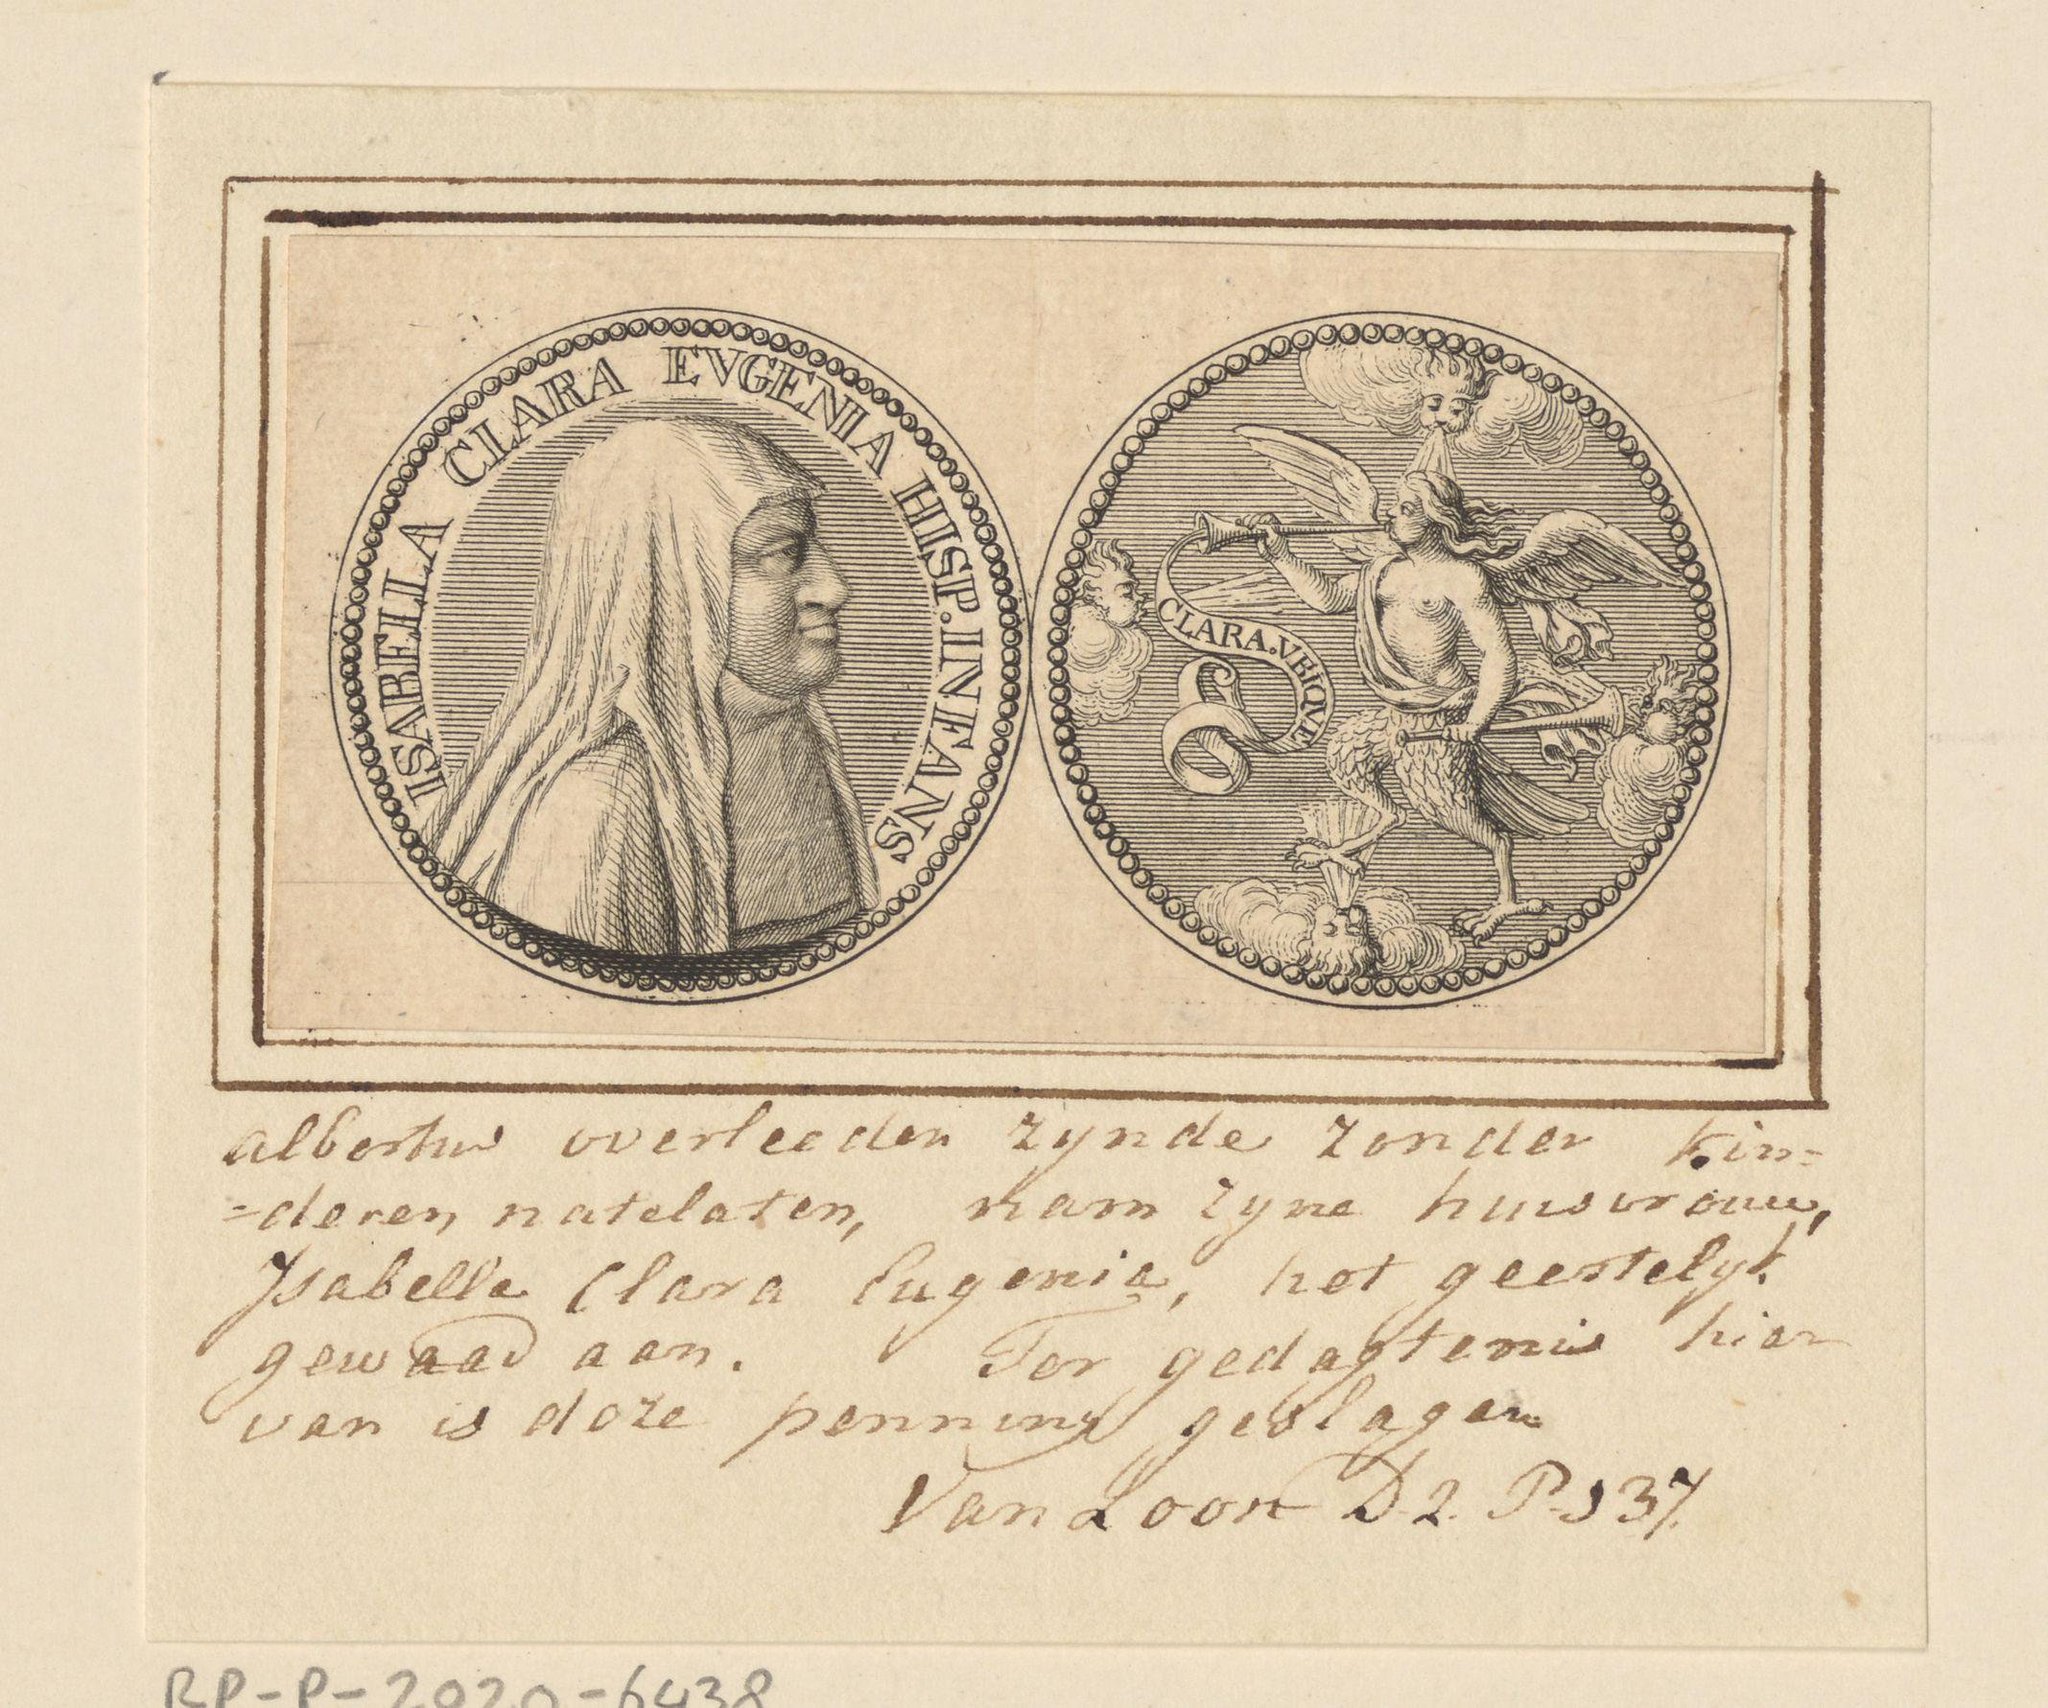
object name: print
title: Penning met portret van Isabella Clara Eugenia, infante van Spanje en een engel met vogelpoten die op een bazuin blaast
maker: Anonymous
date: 1726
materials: paper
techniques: etching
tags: infante van spanje isabella clara eugenia, habit, frock, historical persons - bb - woman, ruler, sovereign - bb - female ruler, angels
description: Prent mogelijk uit: Loon, Gerard van. Beschryving der Nederlandsche historipenningen (...). Den Haag: Christiaan van Lom et al., 1726, dl. 2, p. 137.